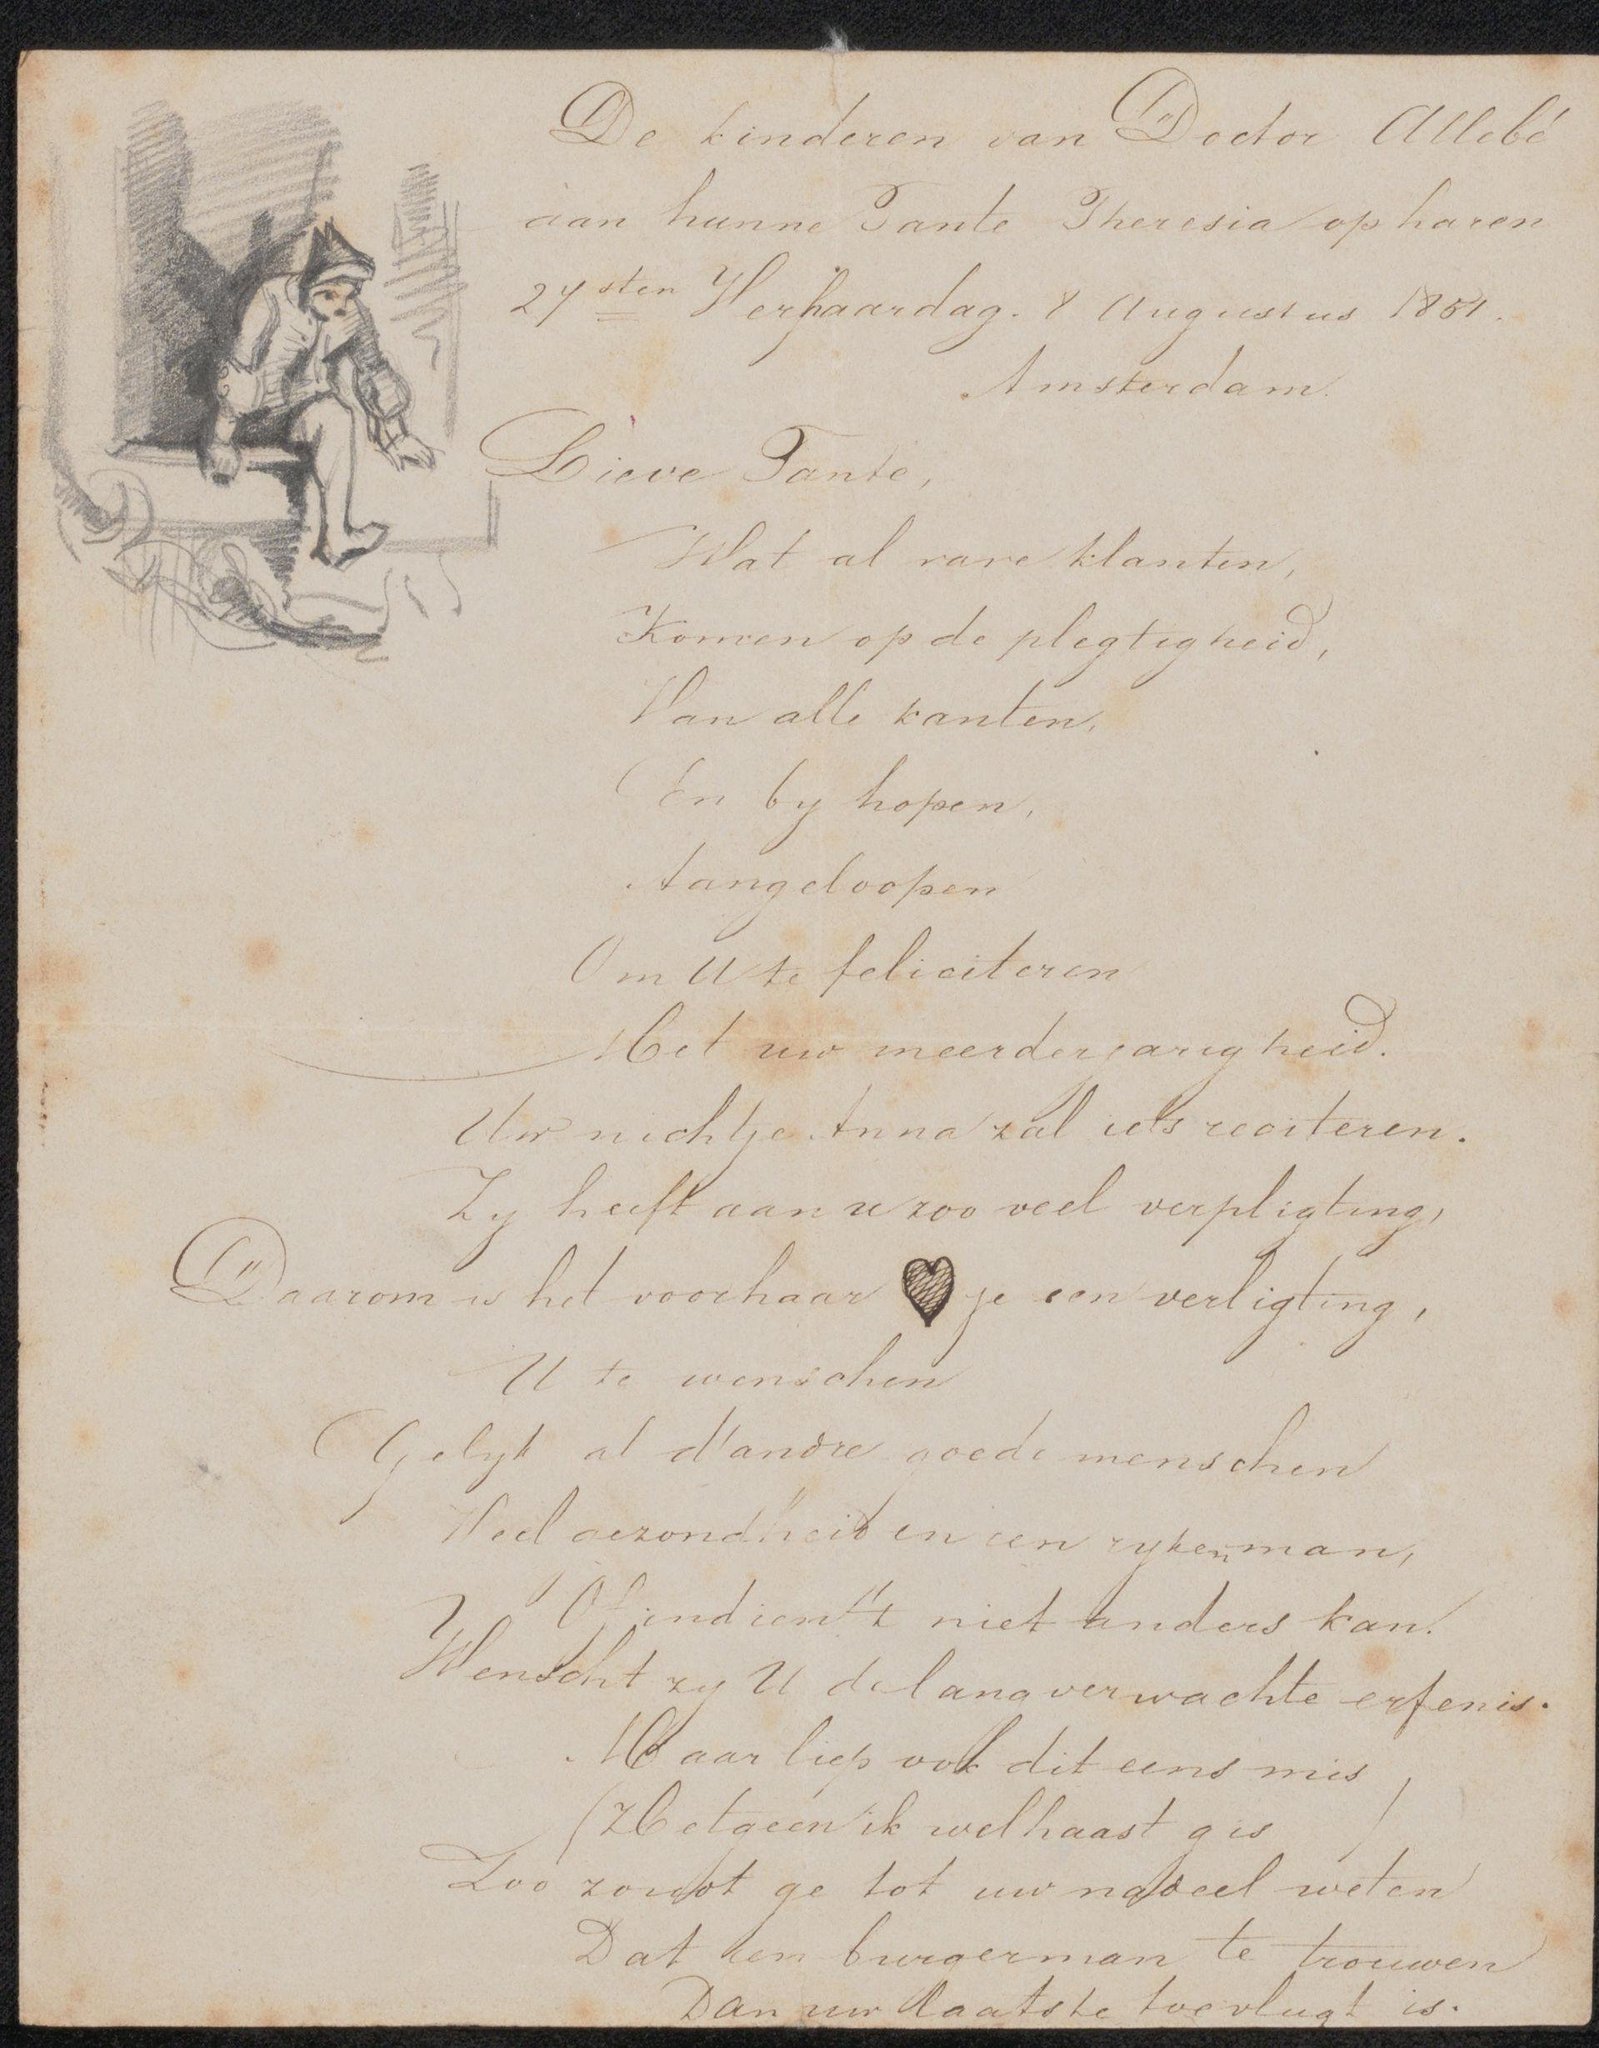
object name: poem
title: Gedicht aan Theresia Augusta Alida Allebé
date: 1833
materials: ink, paper, pencil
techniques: pen, writing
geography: amsterdam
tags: death's head, skull (symbol of death)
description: Gedicht werd bewaard in een bruinleren omslag met goudopdruk `1836 Hulde aan Dr. G.A.N. Allebé 1886', met daarin brieven, tekeningen en gedichten afkomstig uit de familie van de schilder August Allebé.